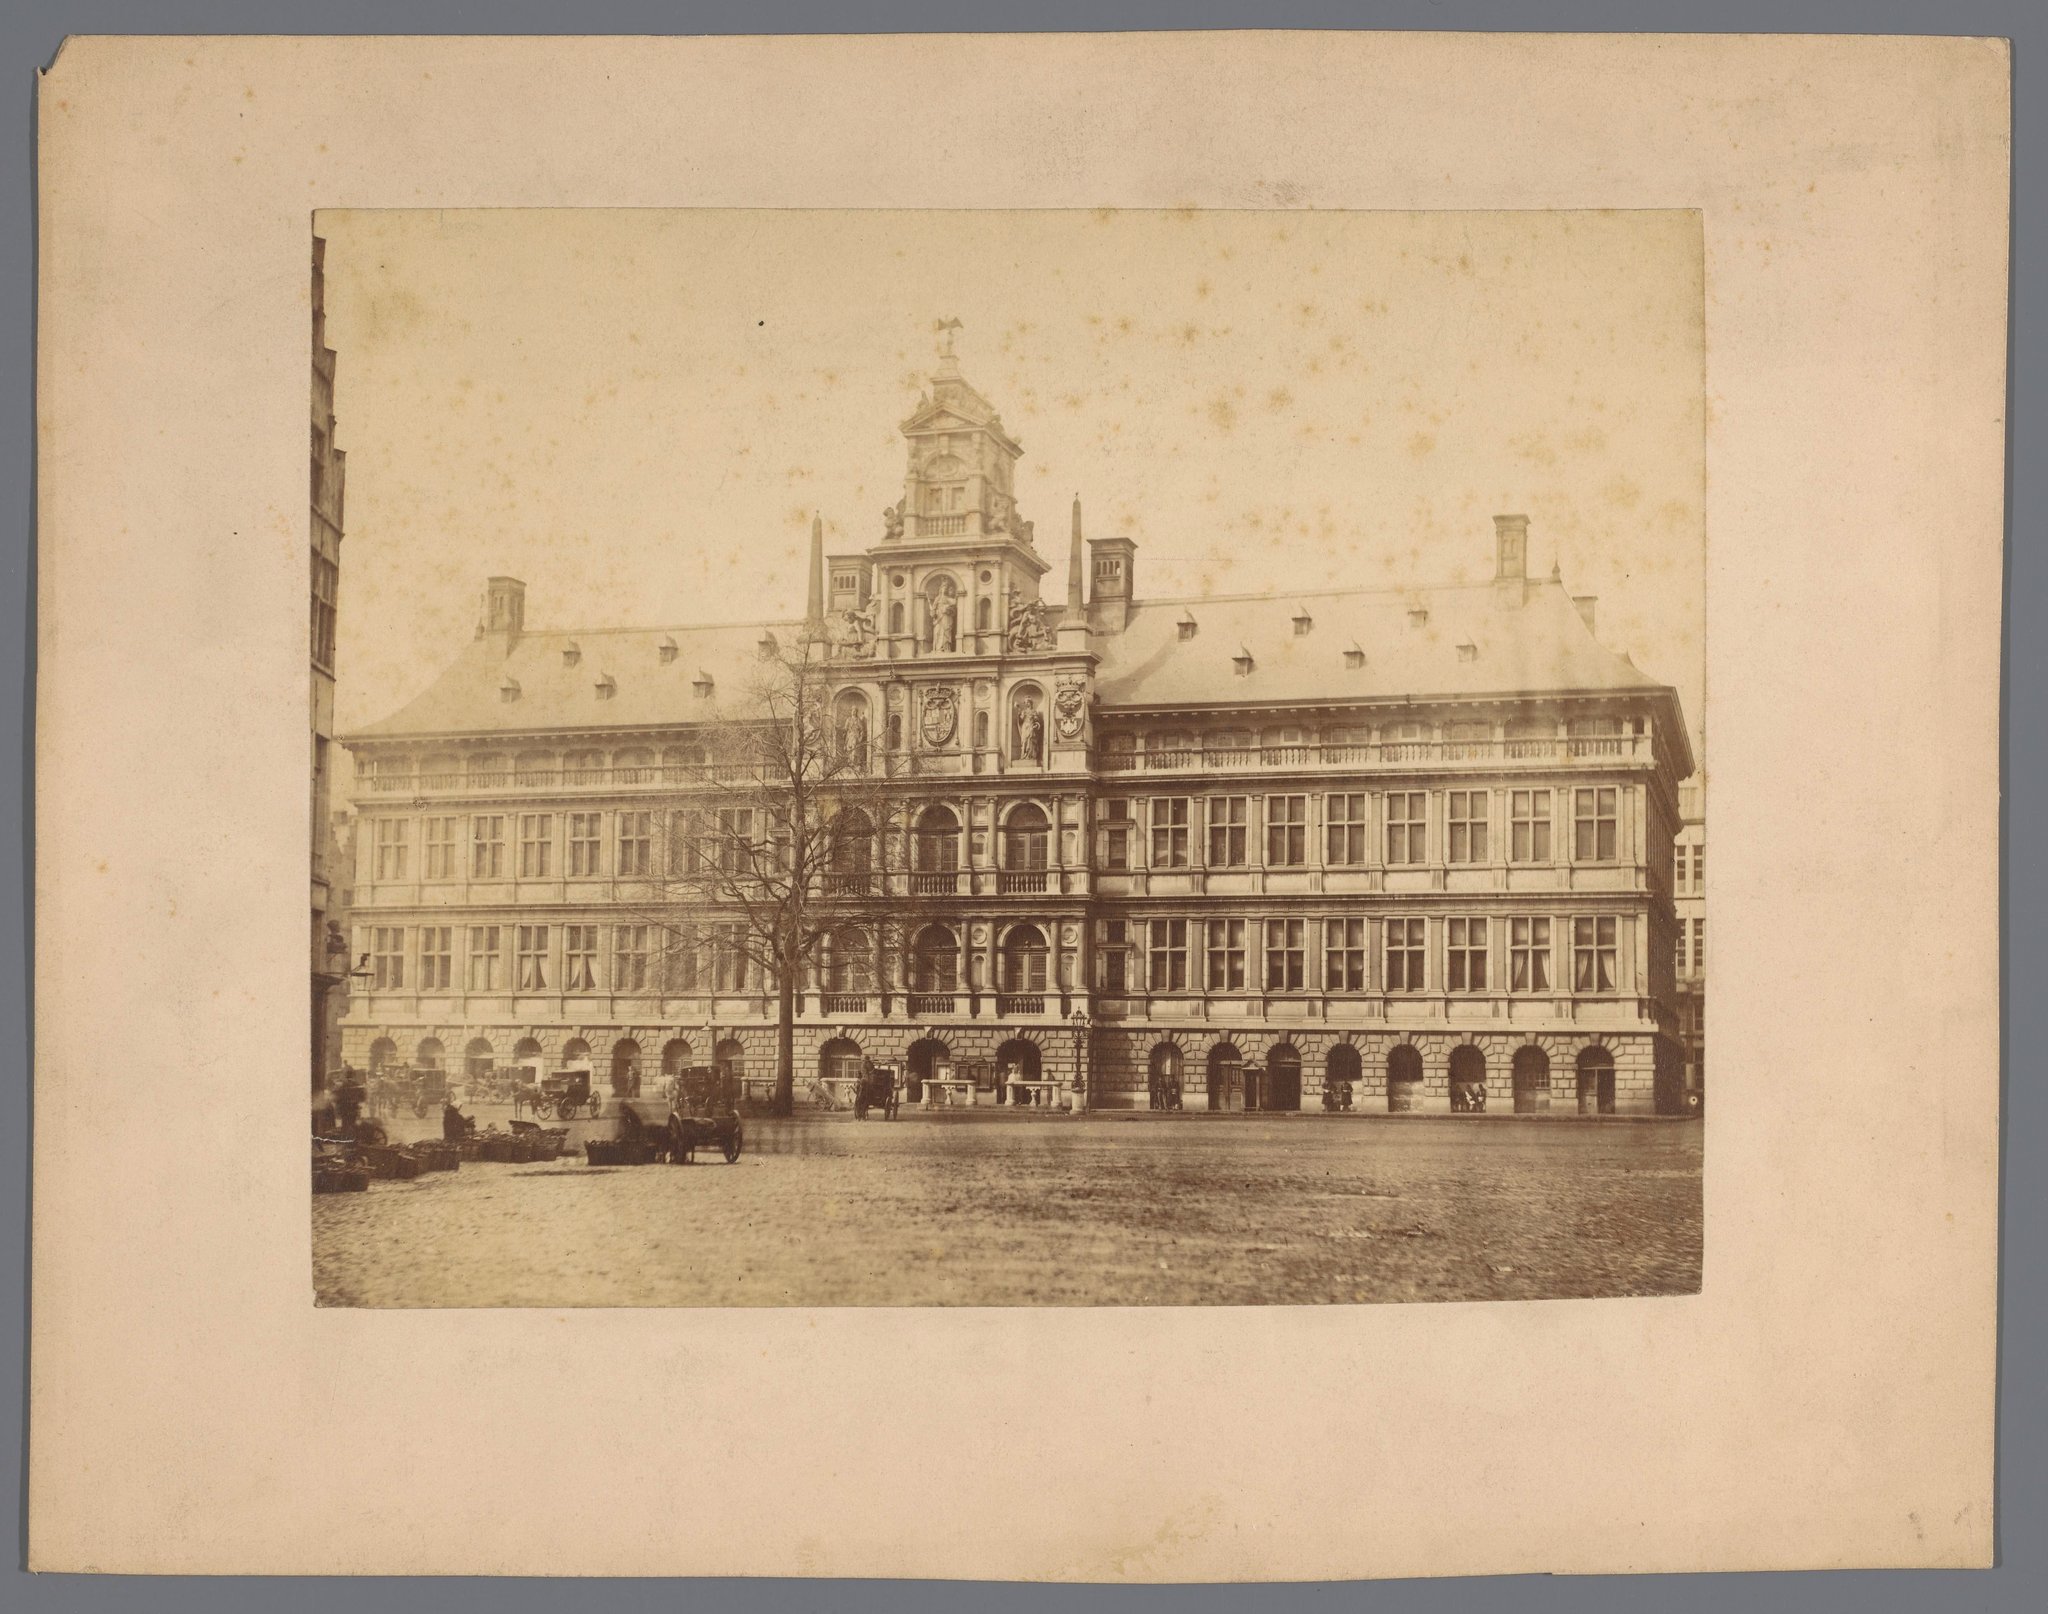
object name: photograph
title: Gezicht op het Stadhuis van Antwerpen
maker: Anonymous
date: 1850-1900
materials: cardboard, photographic support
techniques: albumen print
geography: antwerp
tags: townhall, façade (of house or building)